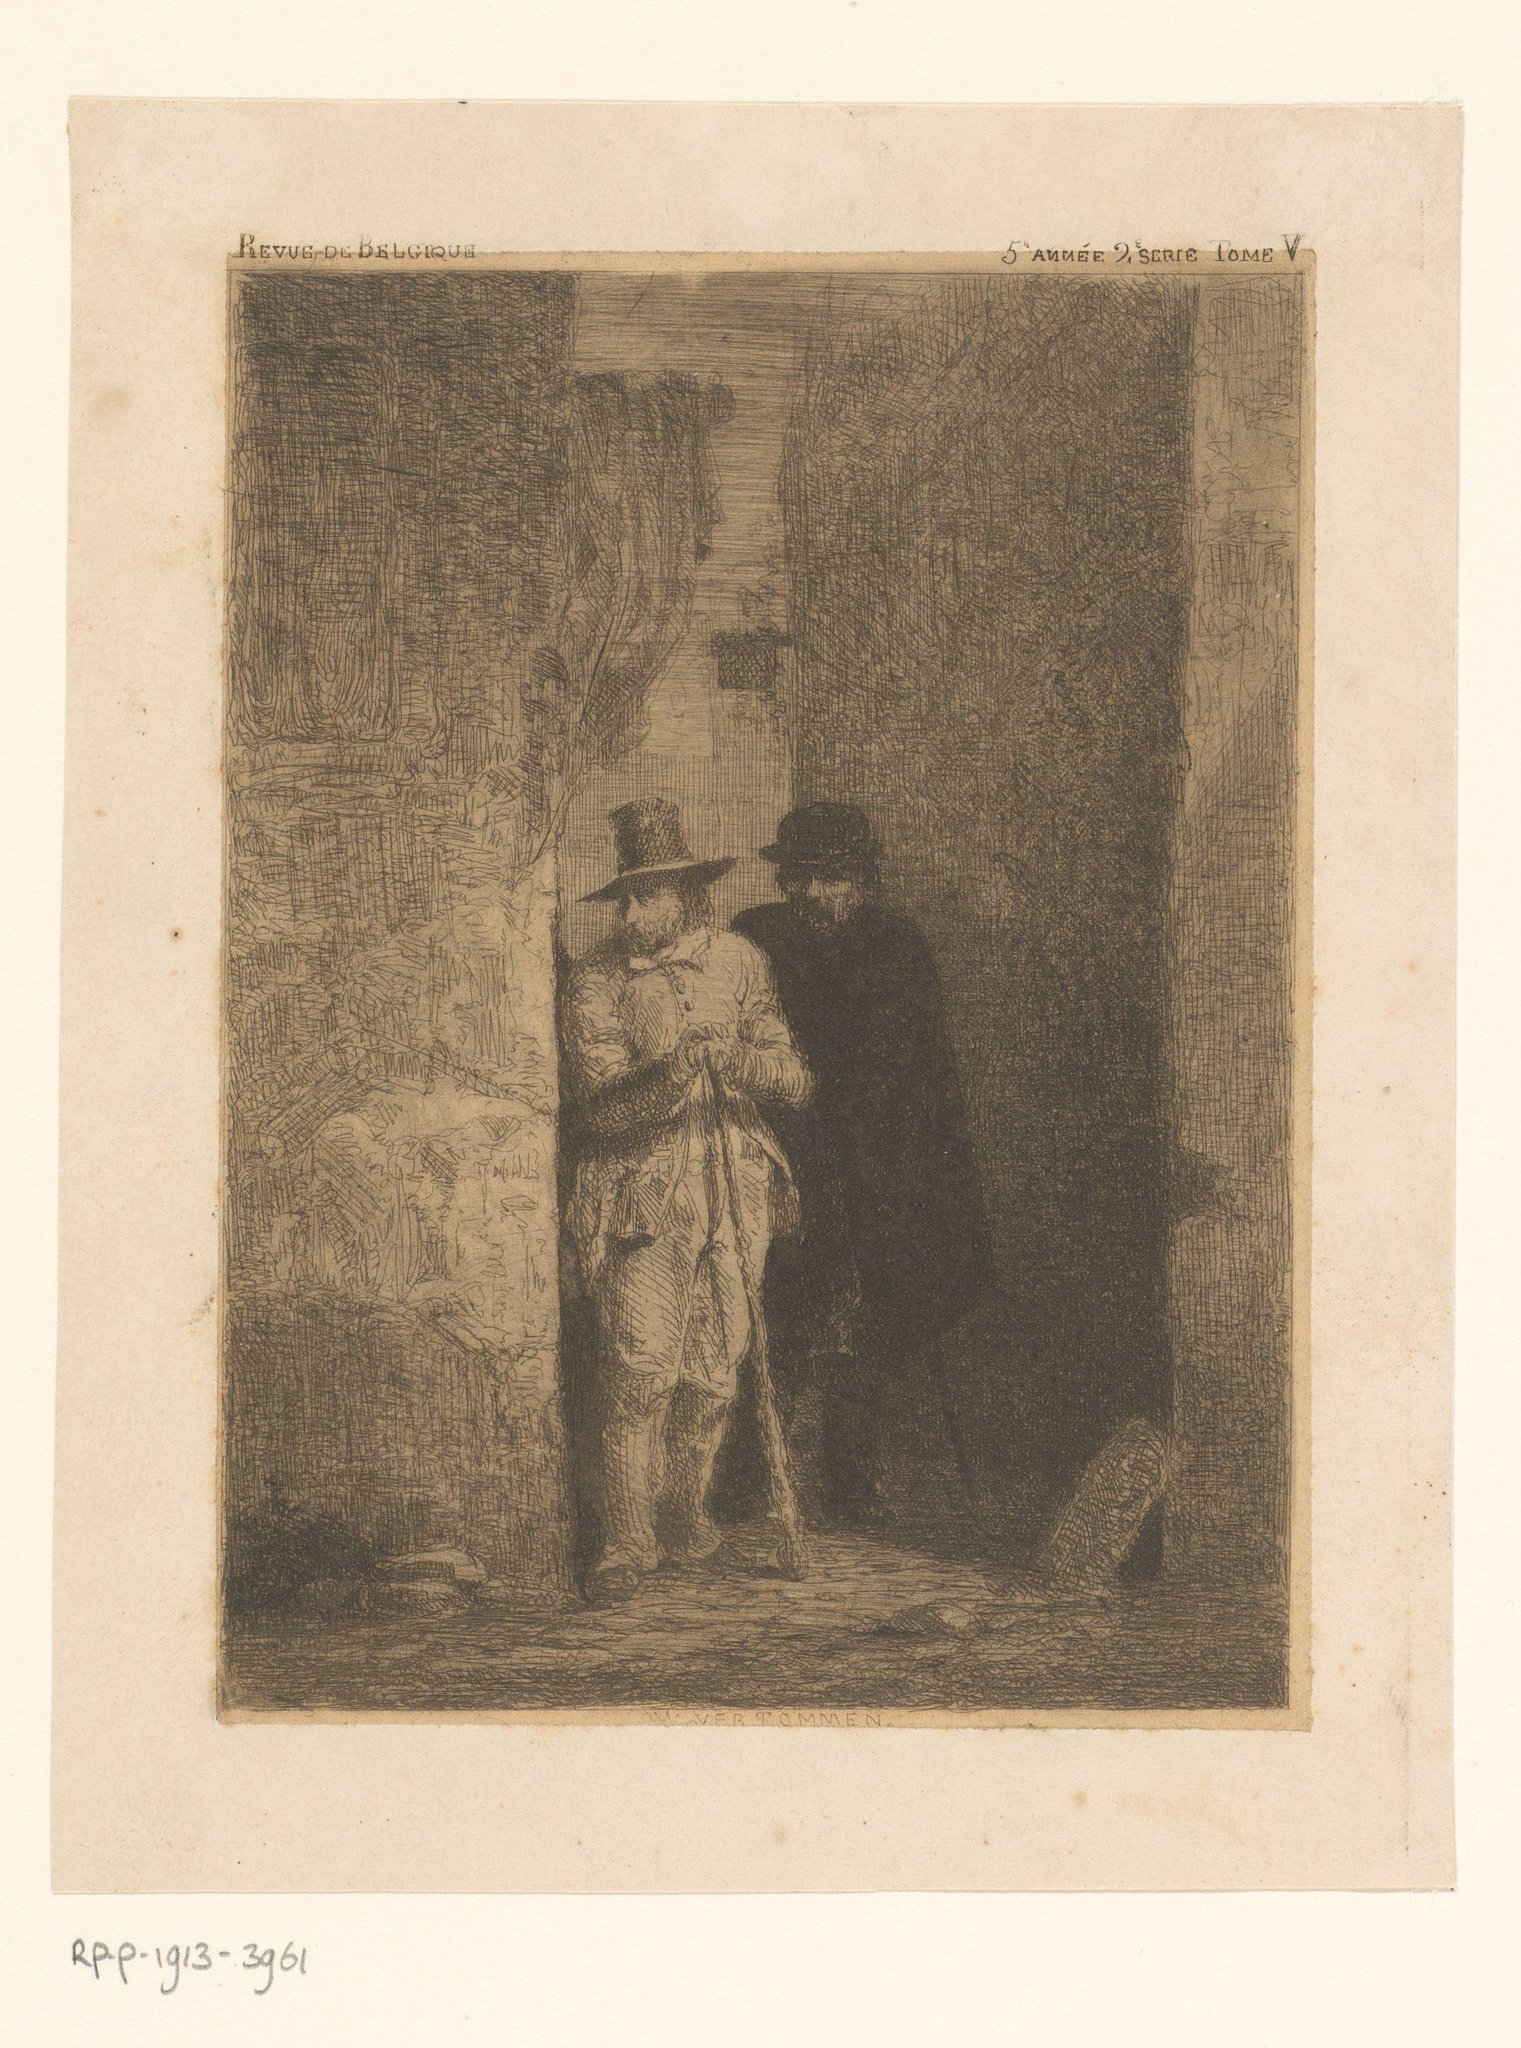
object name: print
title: Twee mannen in een steeg kijken om de hoek van een gebouw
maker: guillaume joseph vertommen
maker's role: print maker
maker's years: 1815-1863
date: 1825-1863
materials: paper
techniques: etching, intaglio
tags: adult man (+ two persons), walking-stick, staff, lane, alley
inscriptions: collector's mark: Lugt 2228, collector's mark: Lugt 1485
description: Prent uit: Revue de Belgique: littérature et beaux-arts.